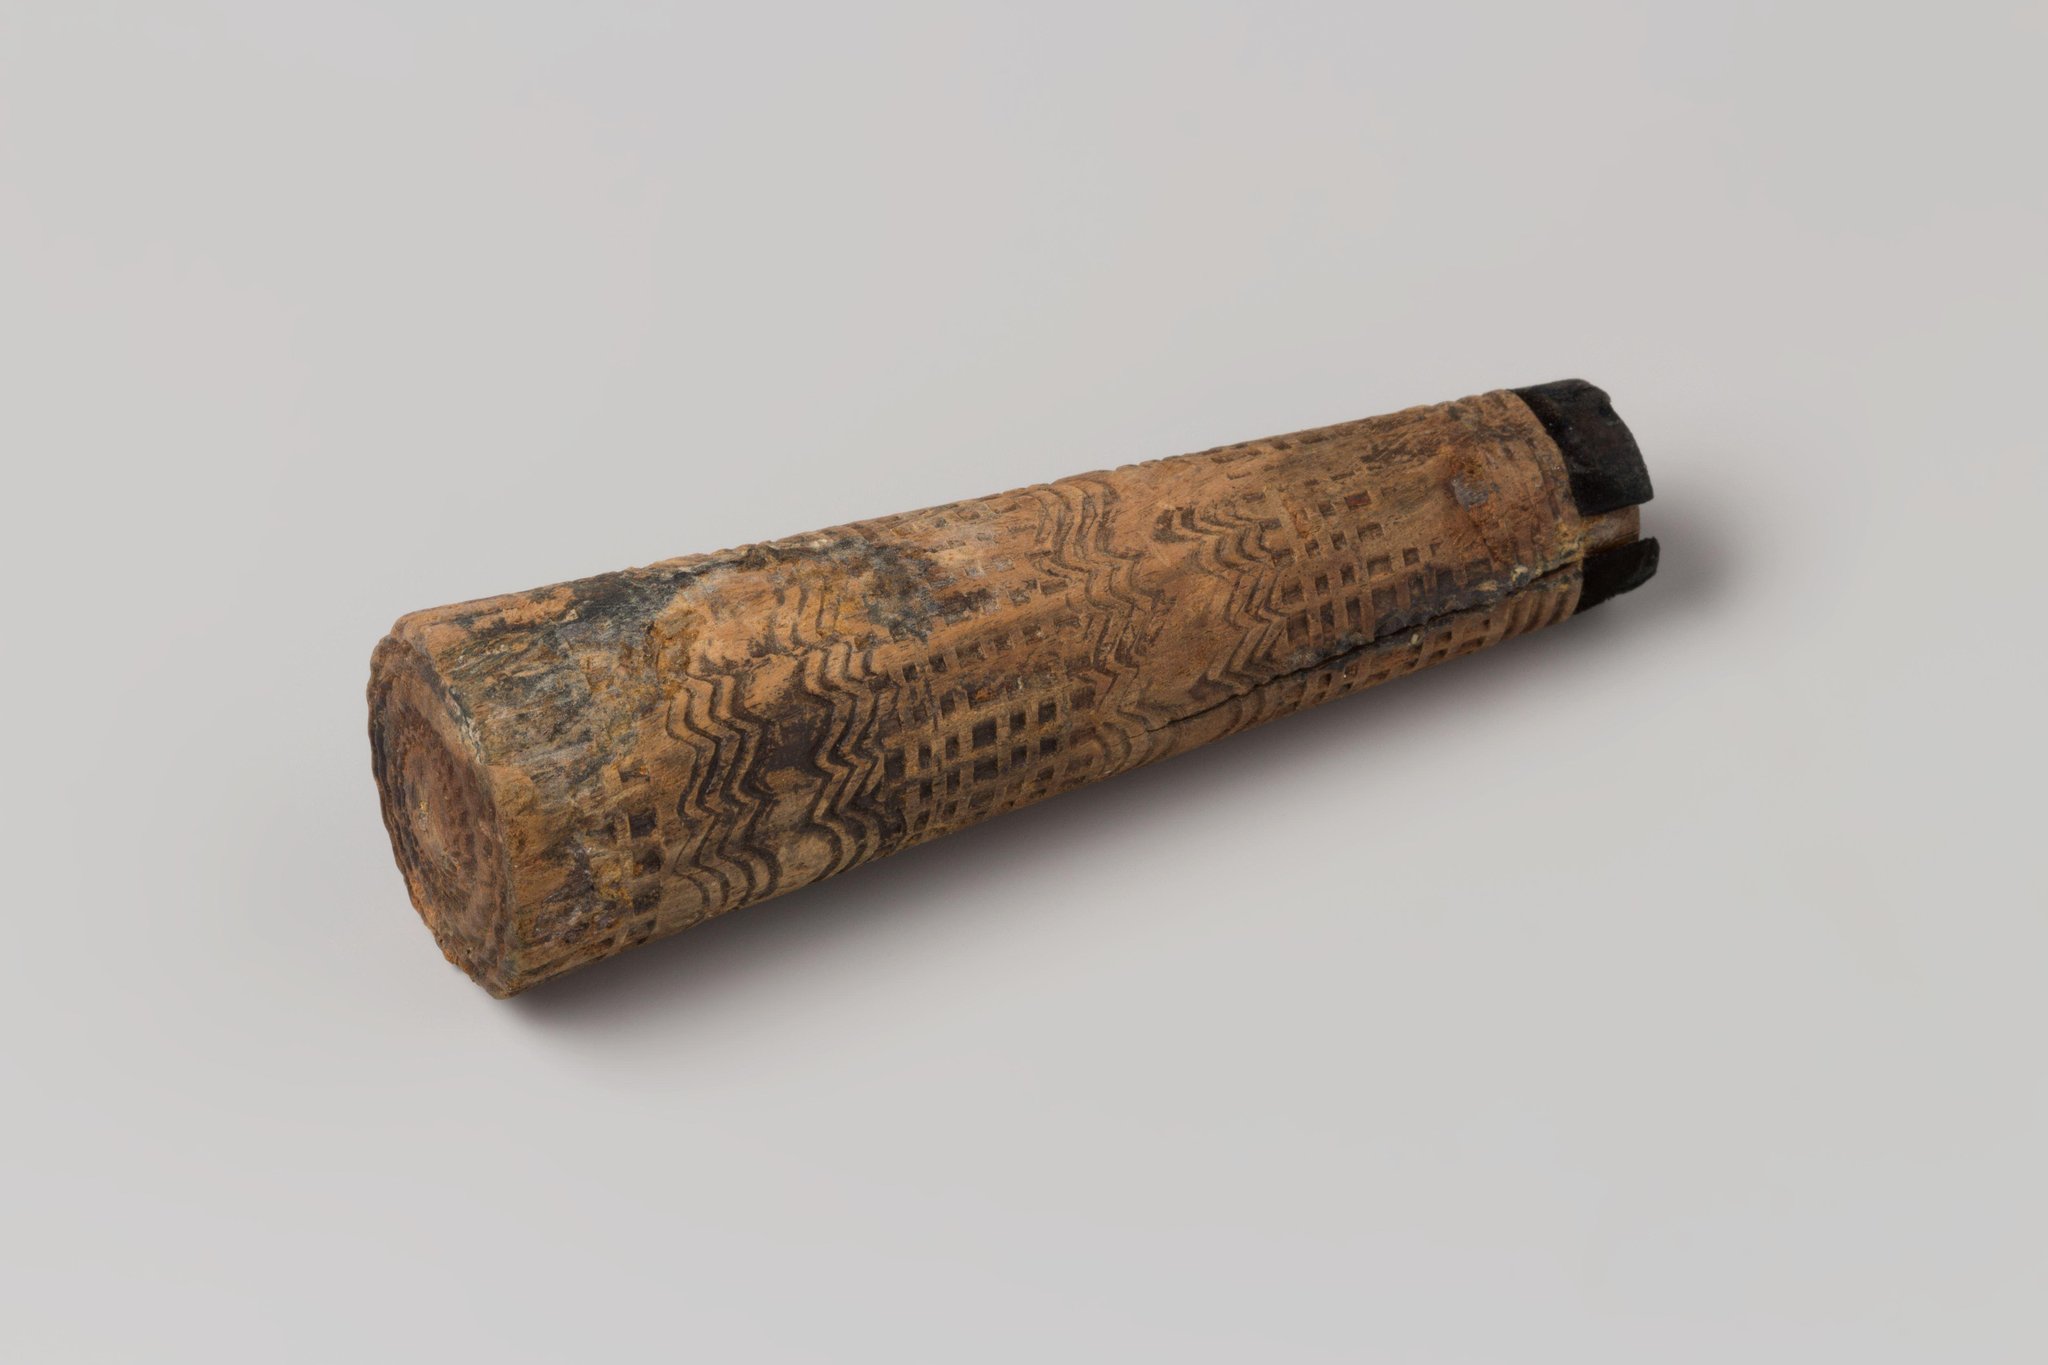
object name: knife handle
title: Messenheft uit het wrak van de Oost-Indiëvaarder Hollandia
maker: Anonymous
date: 1700-1743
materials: copper, wood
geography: netherlands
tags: verenigde oostindische compagnie, hollandia (schip), annet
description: Knife, handle, cylindrical: tapering; id. NG 1979-403H, ferrules, id. NG 1980-27H426.